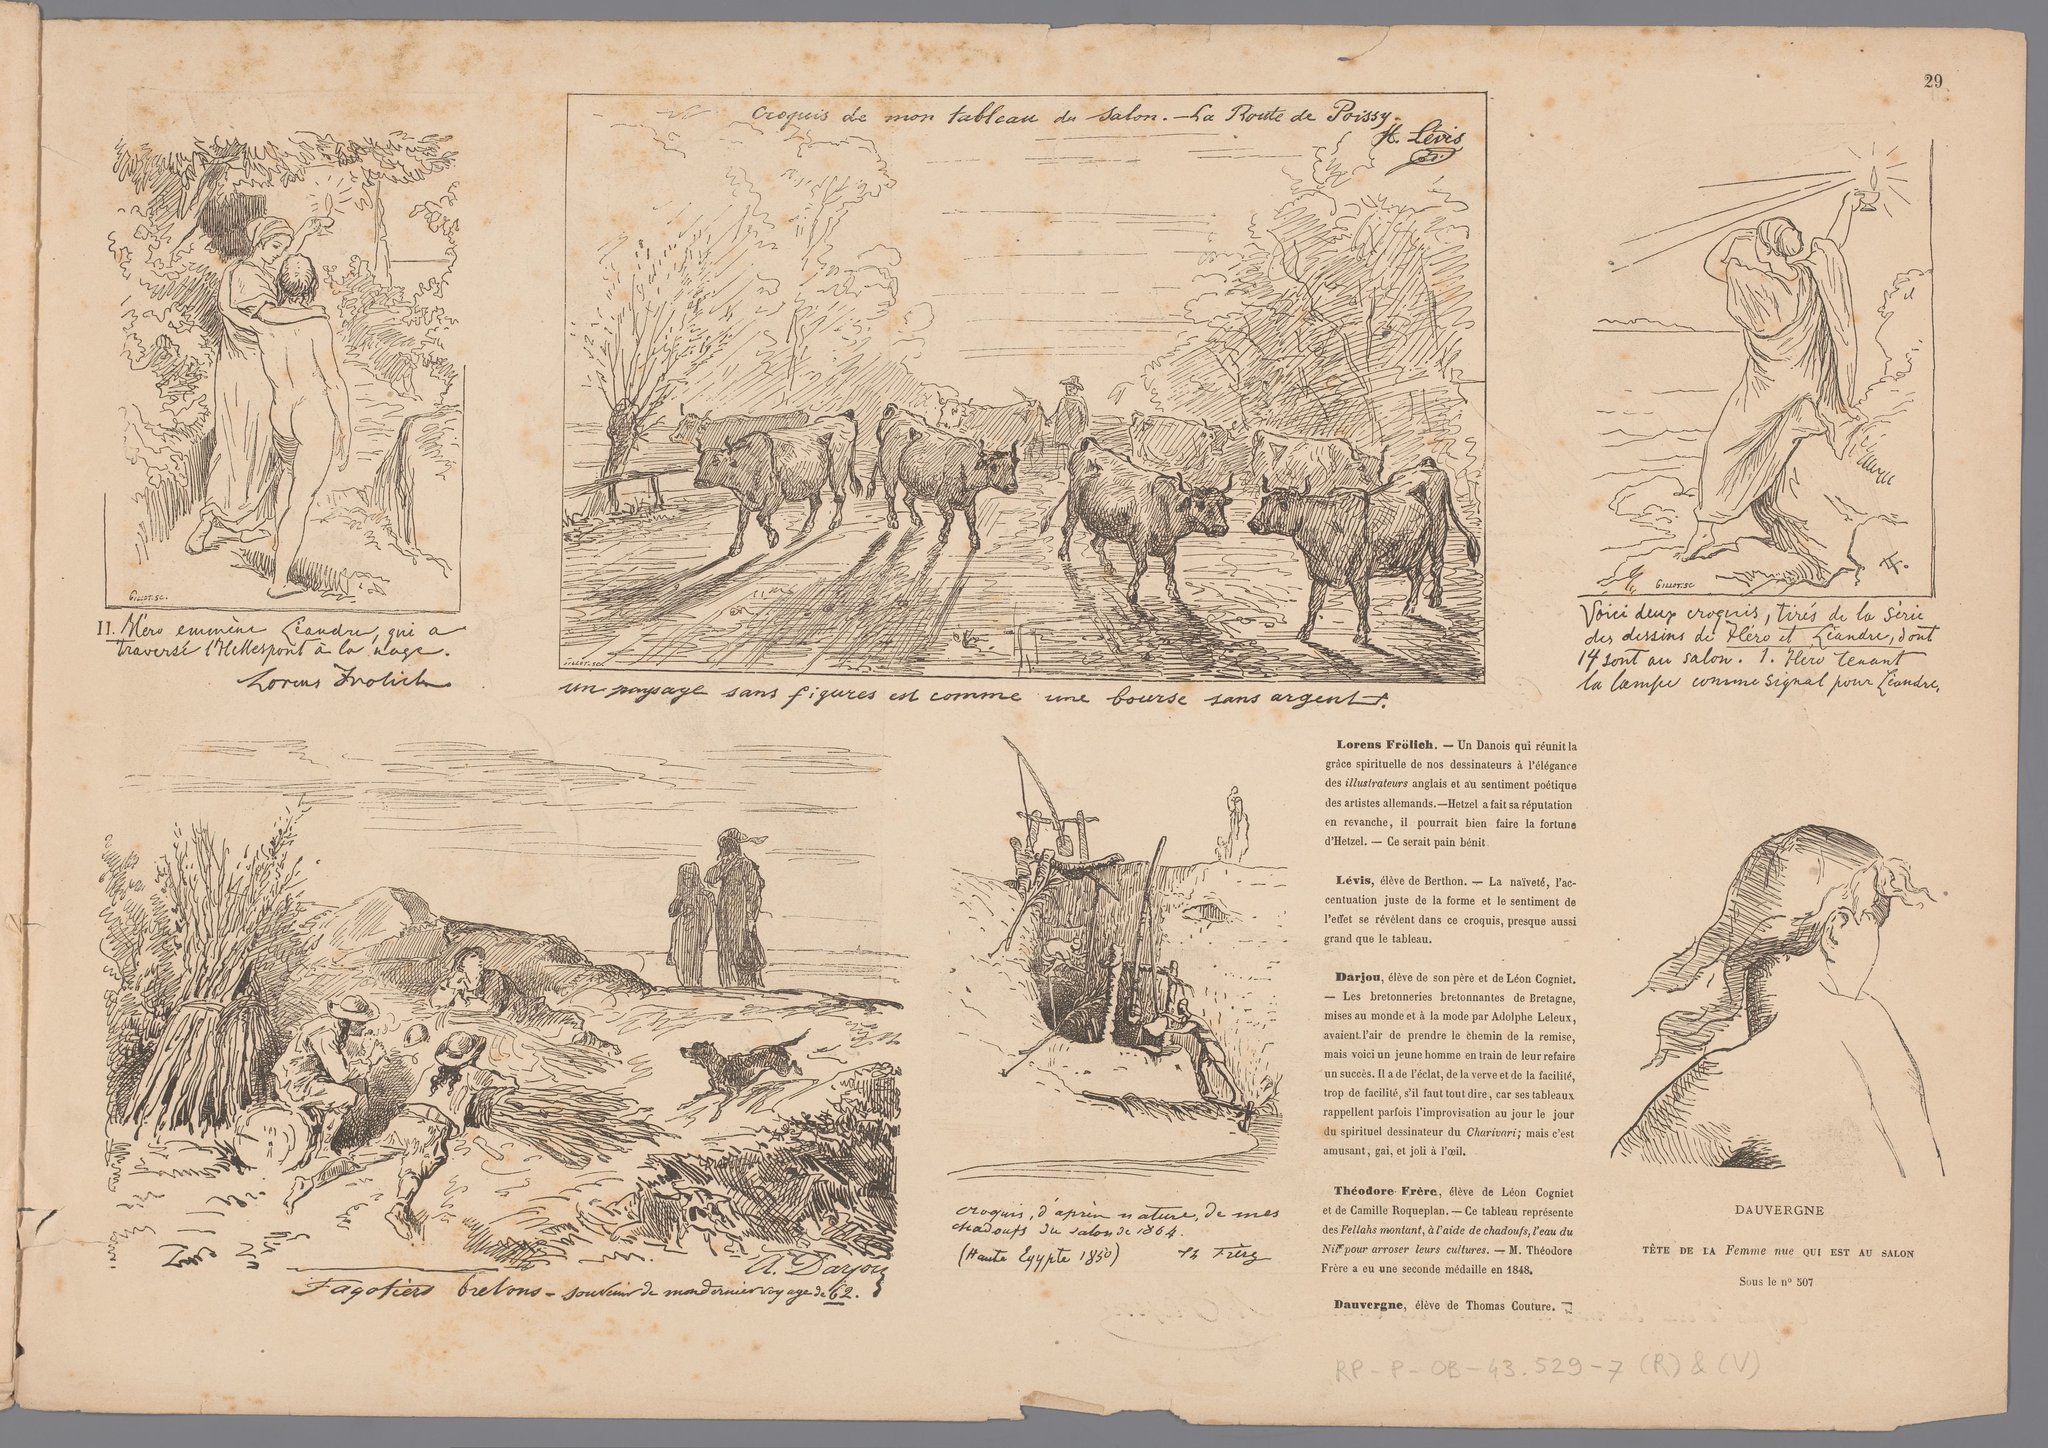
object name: print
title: Hero en Leander, landschap met koeien, Hero met olielamp, rustende maaiers, figuren bij een put en een figuur op de rug gezien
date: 1864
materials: paper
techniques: gillotage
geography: paris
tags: water-supply and draining, pipework (in house or building), (story of) hero and leander, reaping, picking, mowing ~ harvest